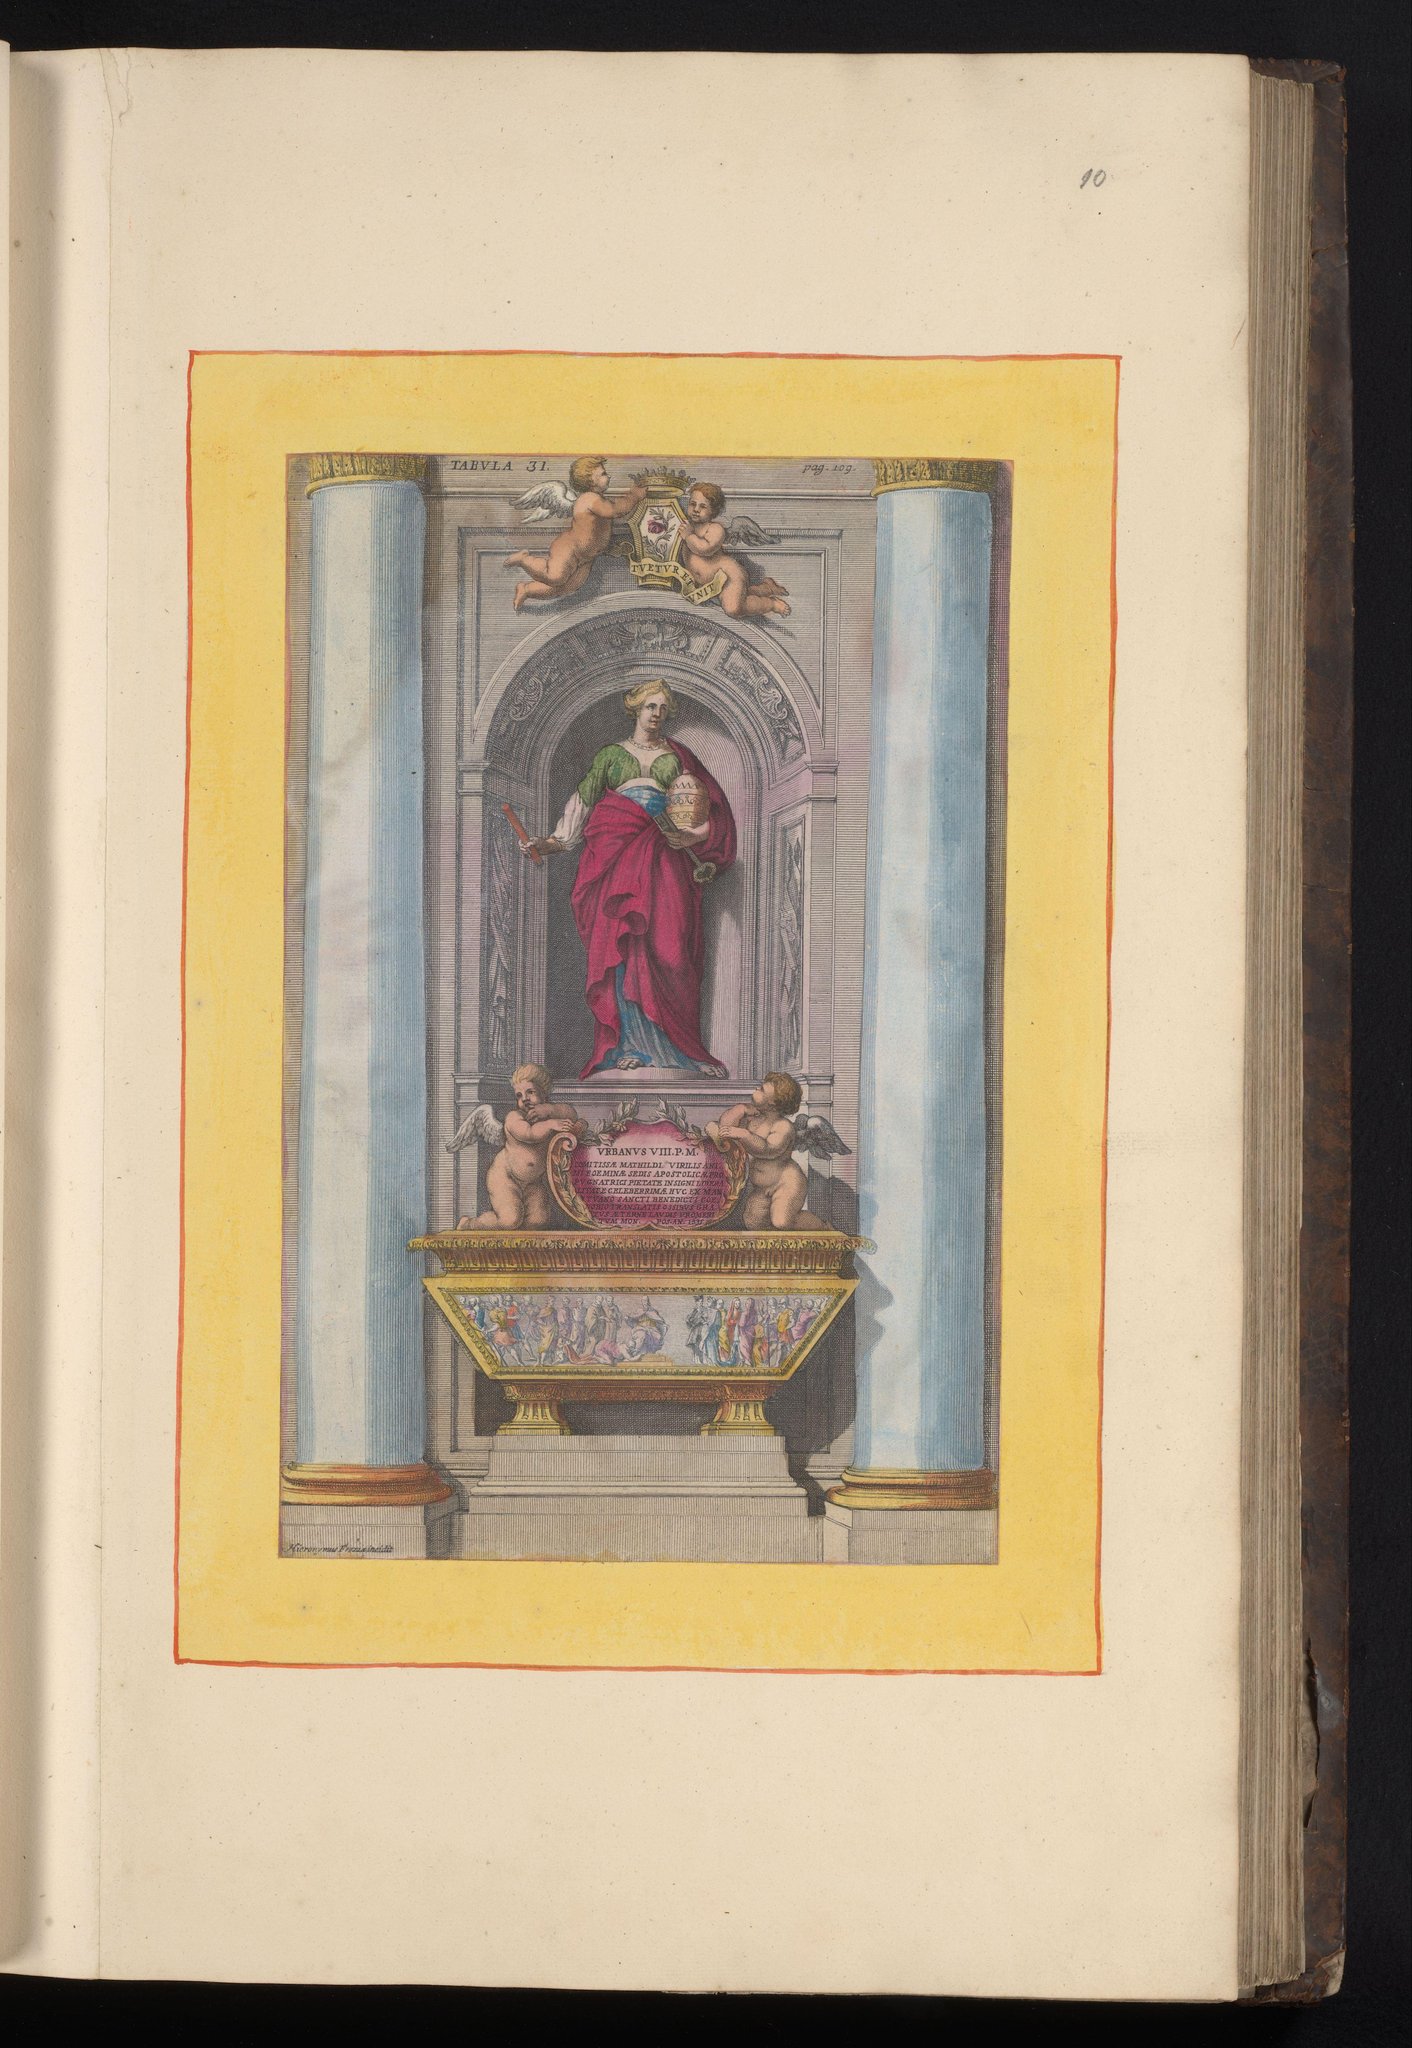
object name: album leaf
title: Grafmonument voor Matilda van Canossa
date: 1693-1717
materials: paper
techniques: colour, etching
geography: the hague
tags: rome, clergyman, urbanus viii, salerno, saints, grave, tomb, sarcophagus, public penance, general avowal of faults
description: Grafmonument voor Matilda van Canossa in de Sint-Pietersbasiliek, gemaakt in opdracht van paus Urbanus VIII. Op de sarcofaag een voorstelling van de boetedoening van keizer Hendrik IV aan paus Gregorius VII aan het hof van Matilda. Op de sarcofaag twee geknielde putti om een cartouche met tekst. Daarboven, in een nis, het beeld van Matilda als beschermster van de paus, met in haar ene hand een scepter of staf en in haar andere hand de pauselijke tiara en sleutel. Boven de nis houden twee putti een wapen met een roos en het devies 'Tuetur et Unit' vast. Genummerd midden boven: Tabula 31/ pag. 109. Prent maakt deel uit van een album.